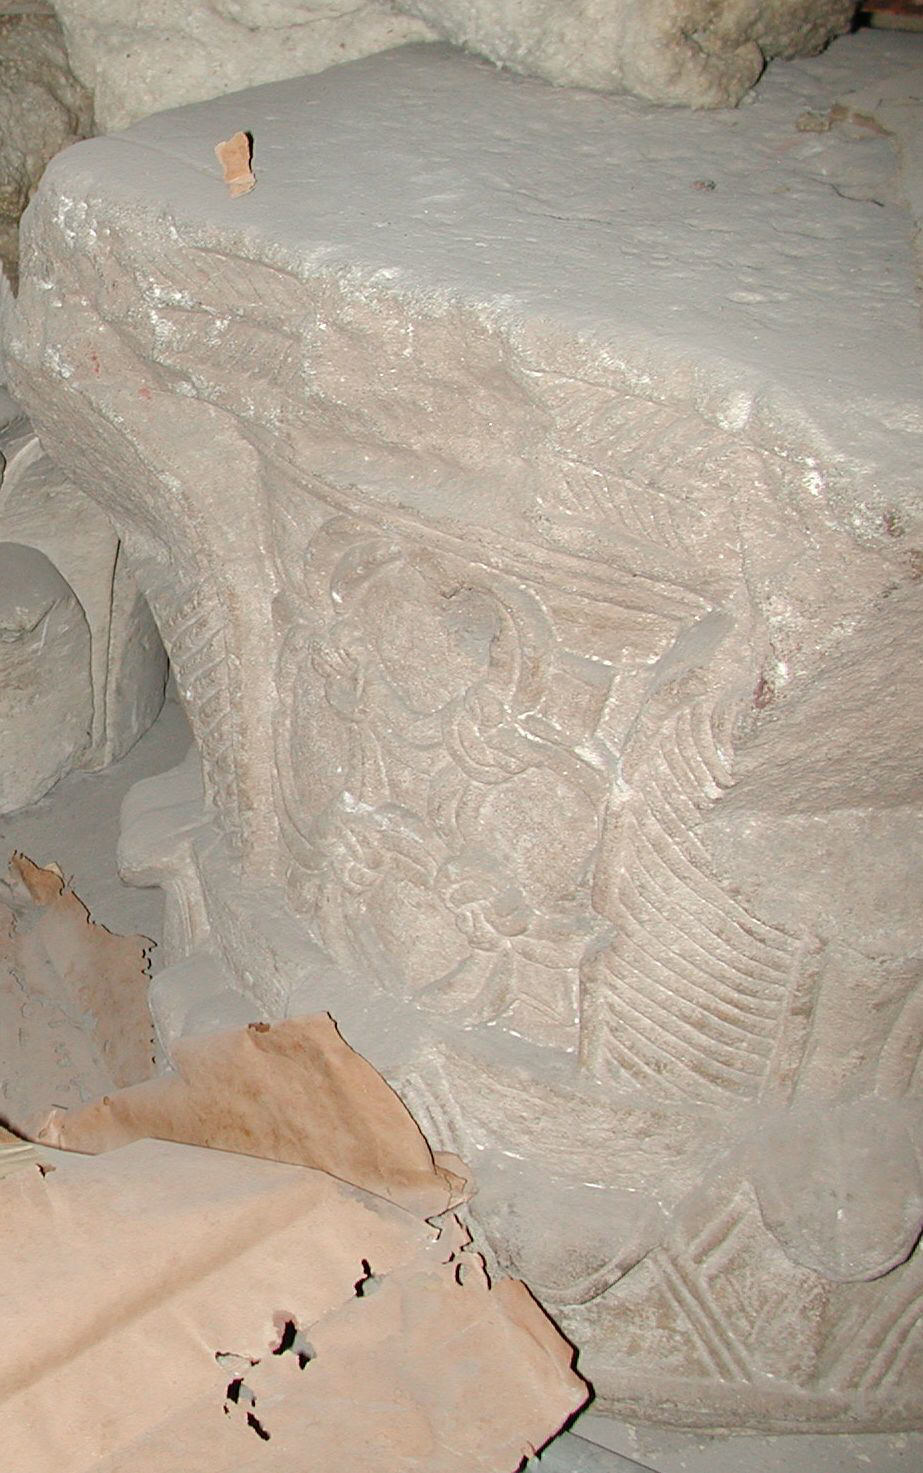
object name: capital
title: Capital with Palm Leaves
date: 401-500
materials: stone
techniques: carving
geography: egypt